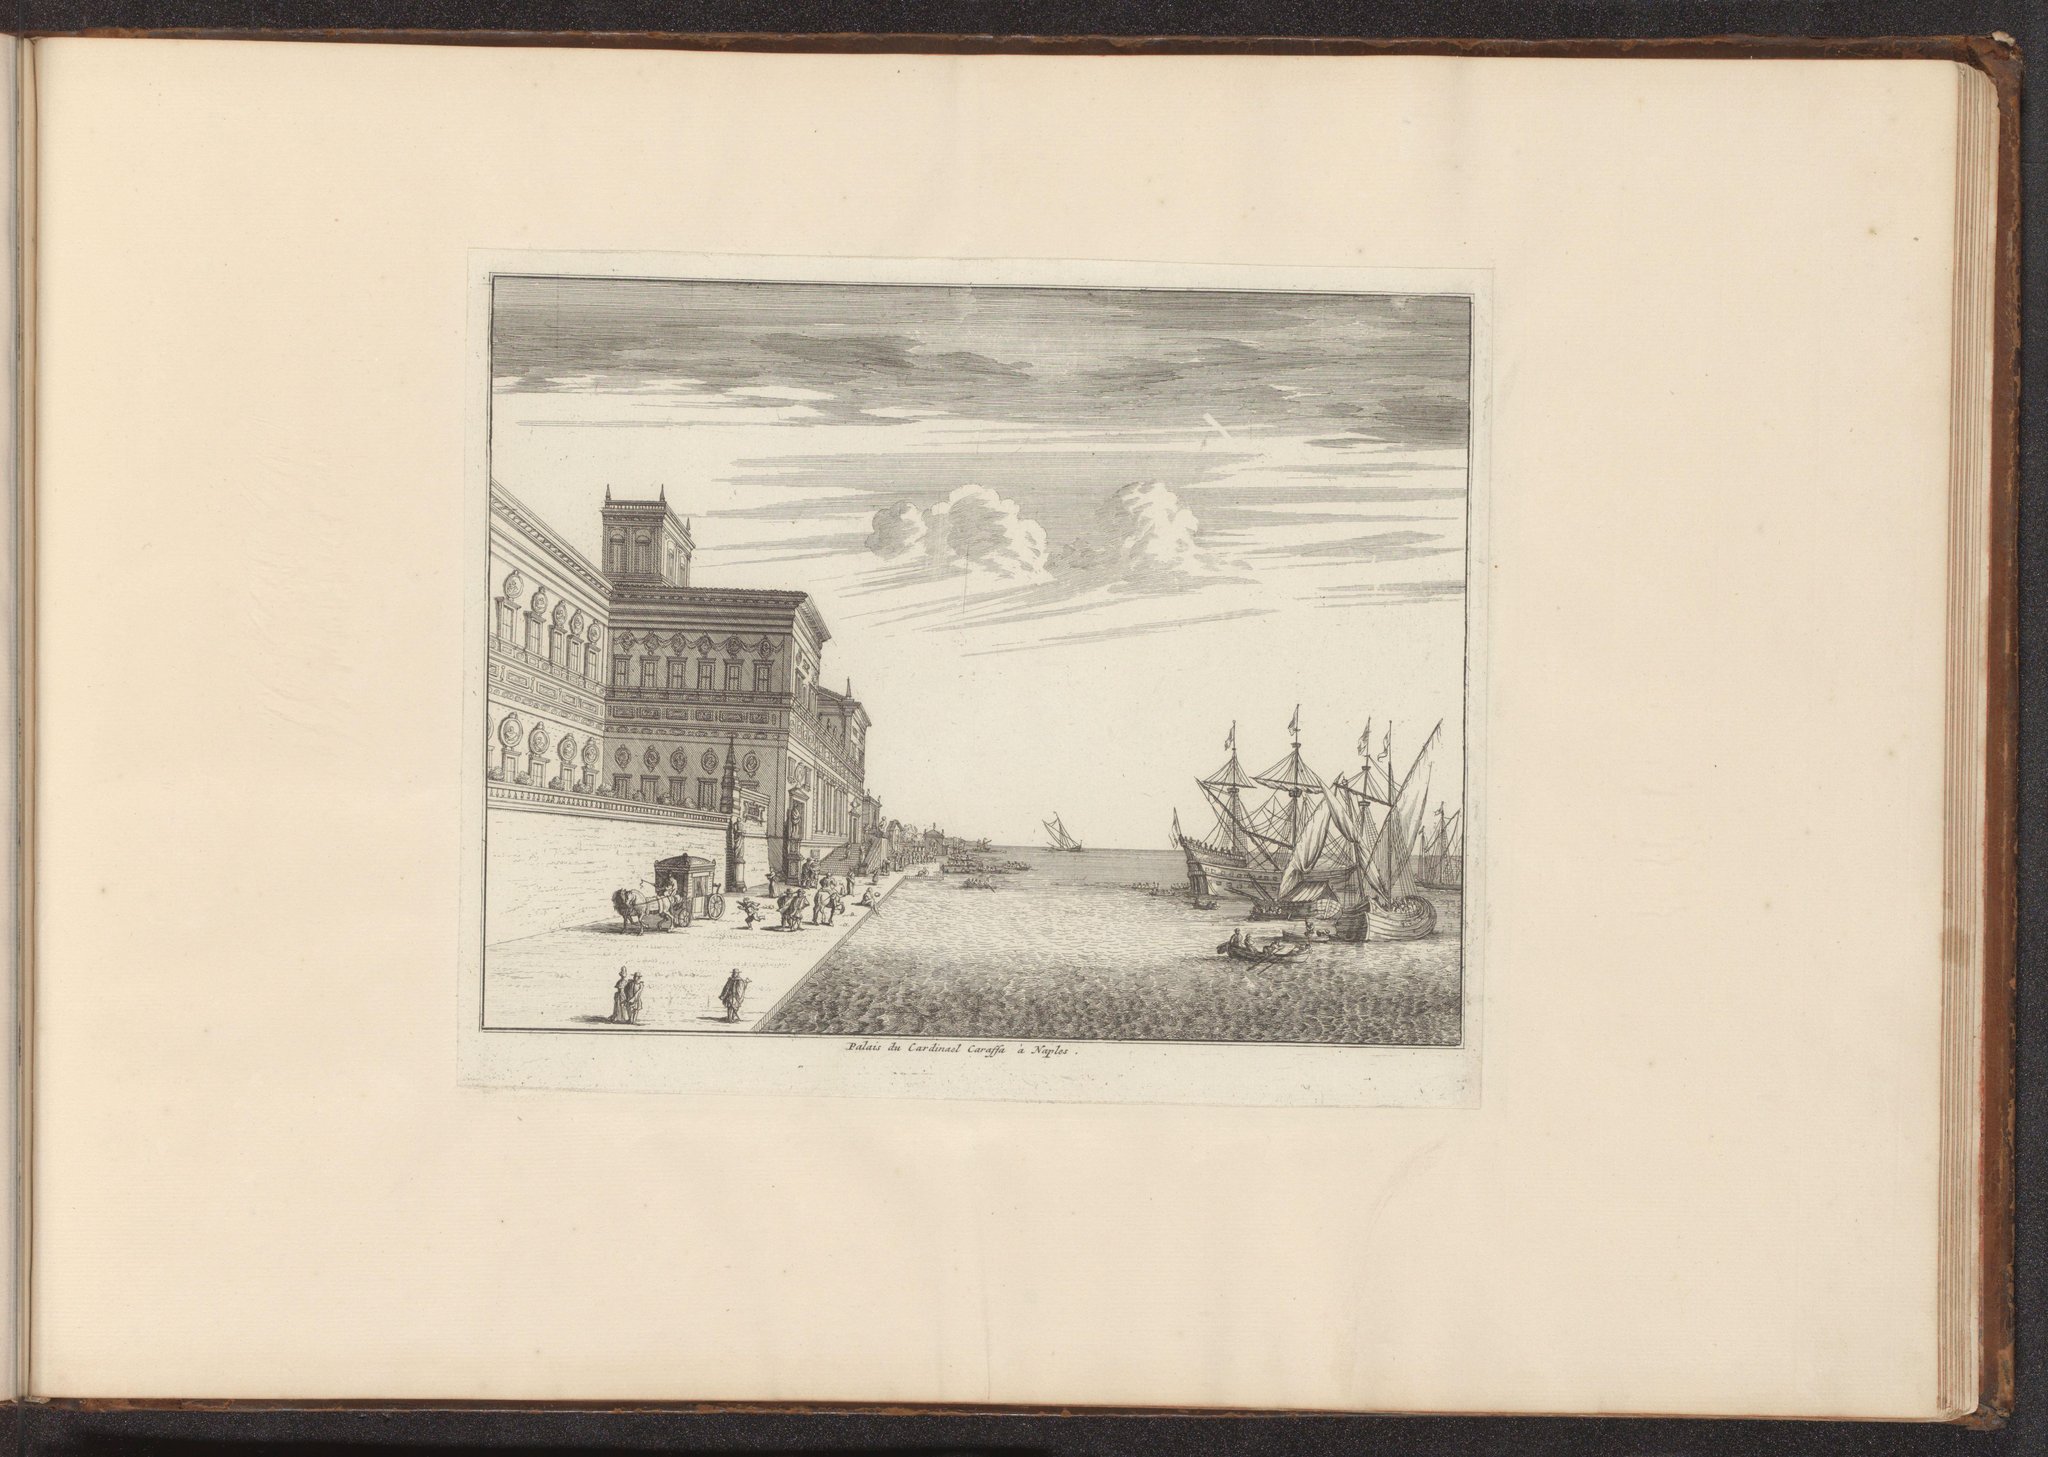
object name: print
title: Paleizen en monumenten in Venetië, Livorno, Napels en Rome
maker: Anonymous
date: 1700-1710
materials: paper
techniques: etching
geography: france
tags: hôtel, i.e. small palace in city, sea, naples